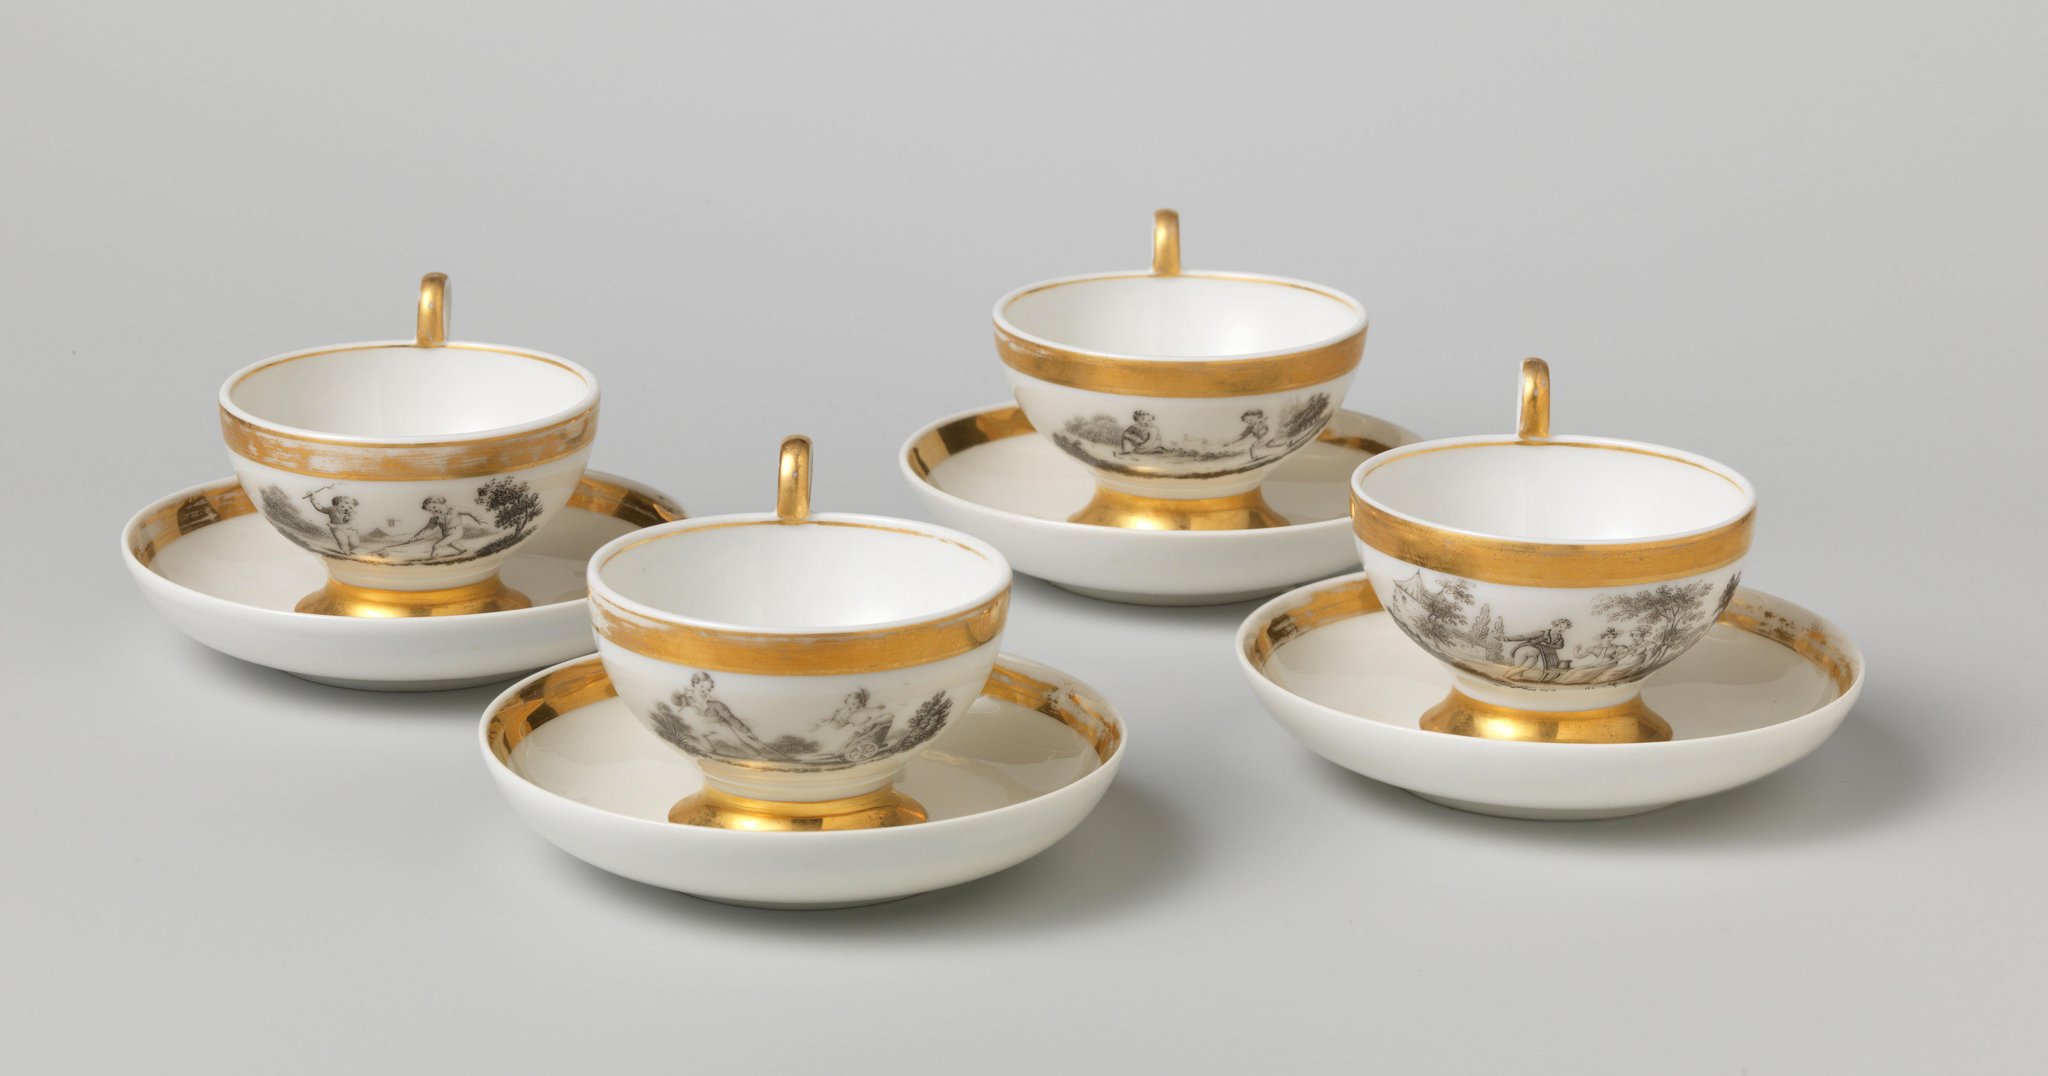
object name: service set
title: Service with different figures in a landscape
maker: Anonymous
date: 1850-1899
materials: glaze, gold, paint, porcelain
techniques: firing, forming, gilding, turning, vitrification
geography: europe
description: Twaalf koppen en schotels van porselein. Koppen op hoge voet en met vraagtekenvormig oor. Op voet en langs mond- en schotelrand een brede gouden bies, het oor verguld; midden op de schotels een gouden cirkel. Eén schotel is groter en heeft twee gouden cirkels o het plat en een smalle gouden bies langs de rand. De koppen versierd met een drukdecor in zwart, voorstellende spelende kinderen of volwassenen in een landschap. De koppen met inv.nrs. BK-1969-155-1,2,4 en 11 hebben eenzelfde decoratie. Slechts één schotel gemerkt: ingegrifte II (inv.nr. BK-1969-155-24).